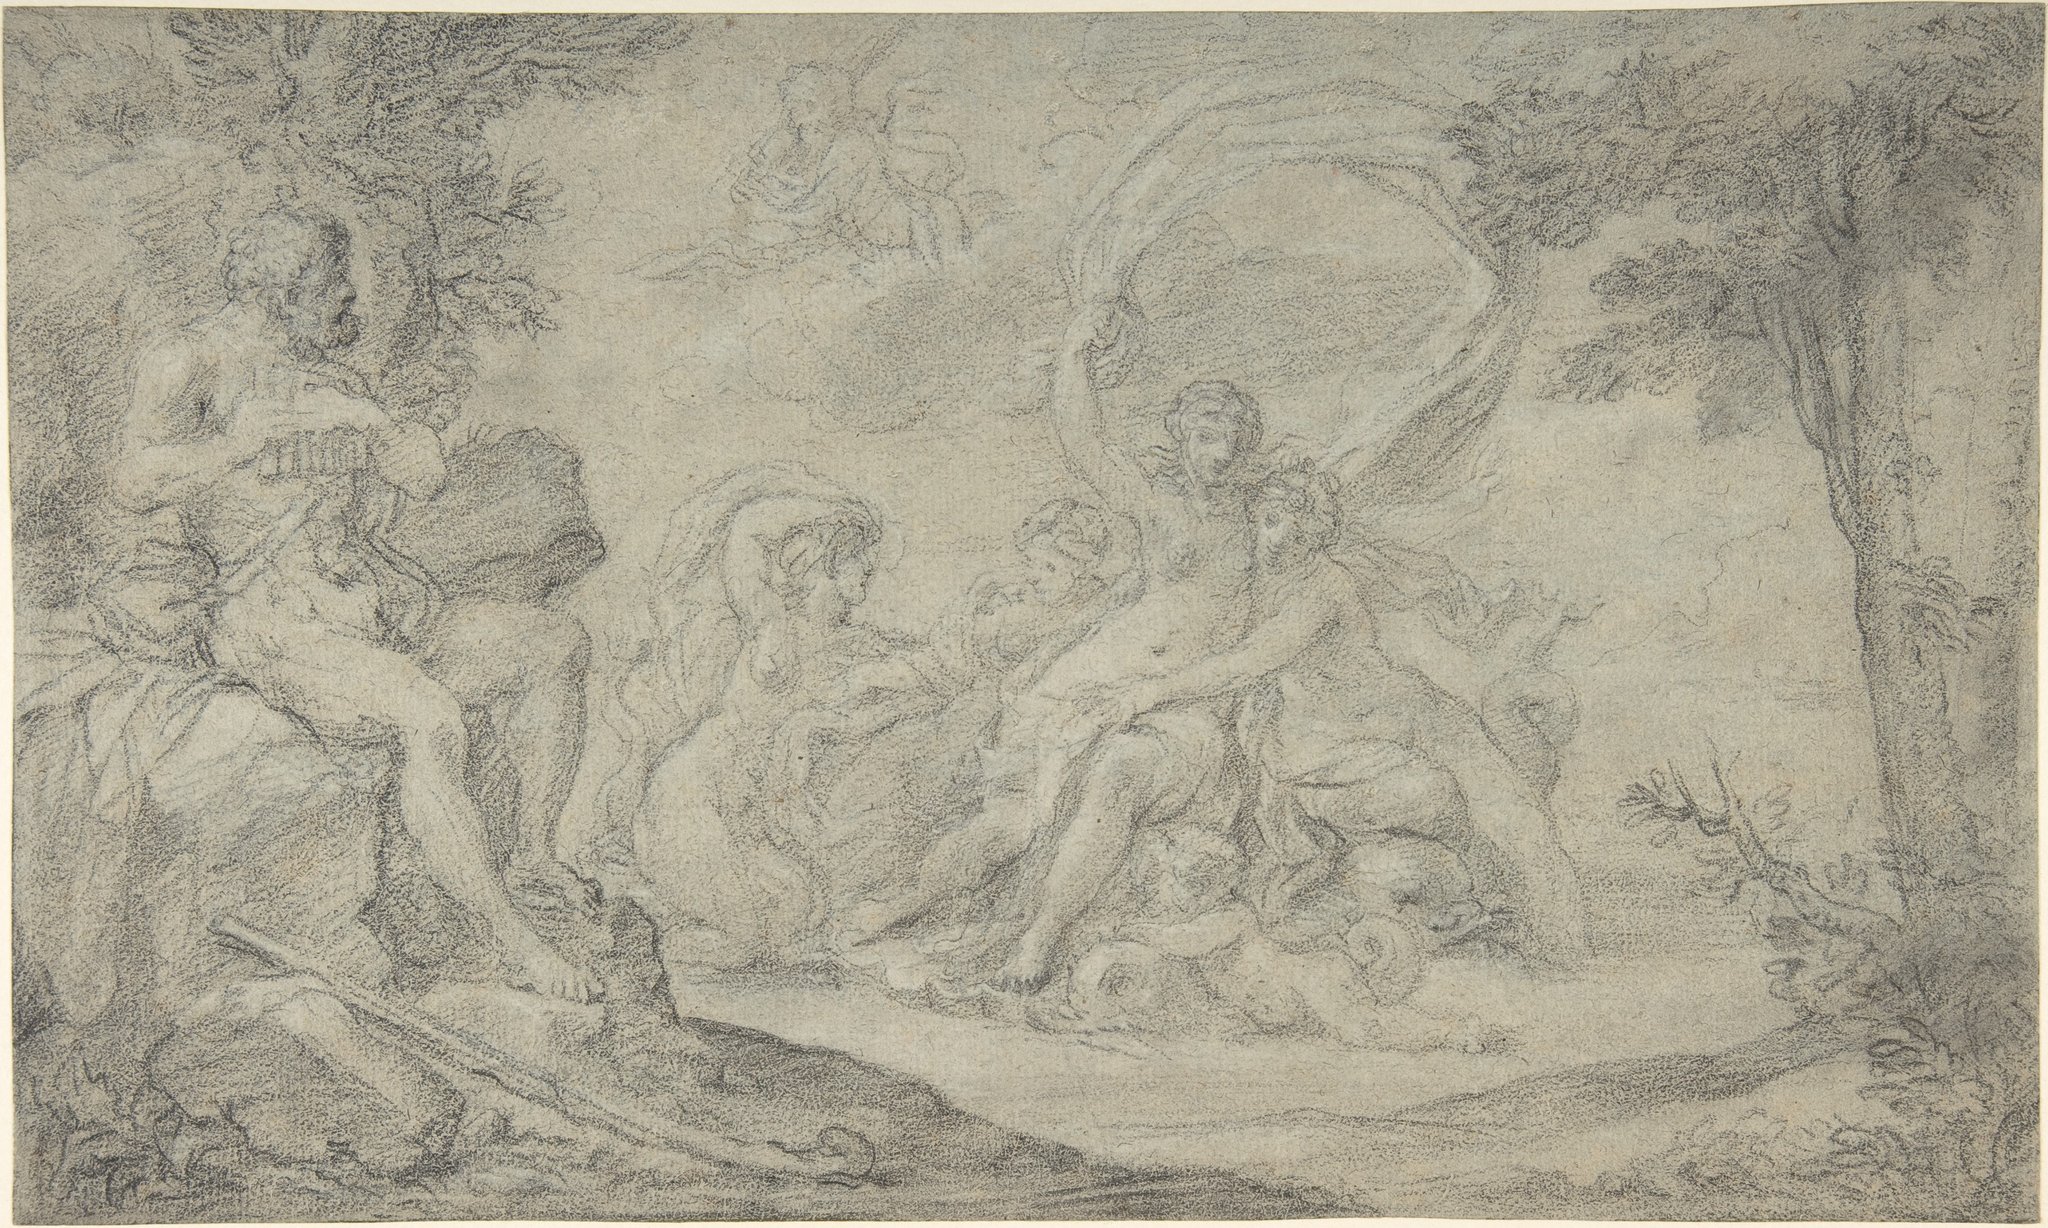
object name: drawing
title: Polyphemus and Galatea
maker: anonymous, italian, 17th century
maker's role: artist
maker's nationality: italian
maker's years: 1600-1700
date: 1701-1800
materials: chalk, paper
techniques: highlighting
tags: male nudes,female nudes